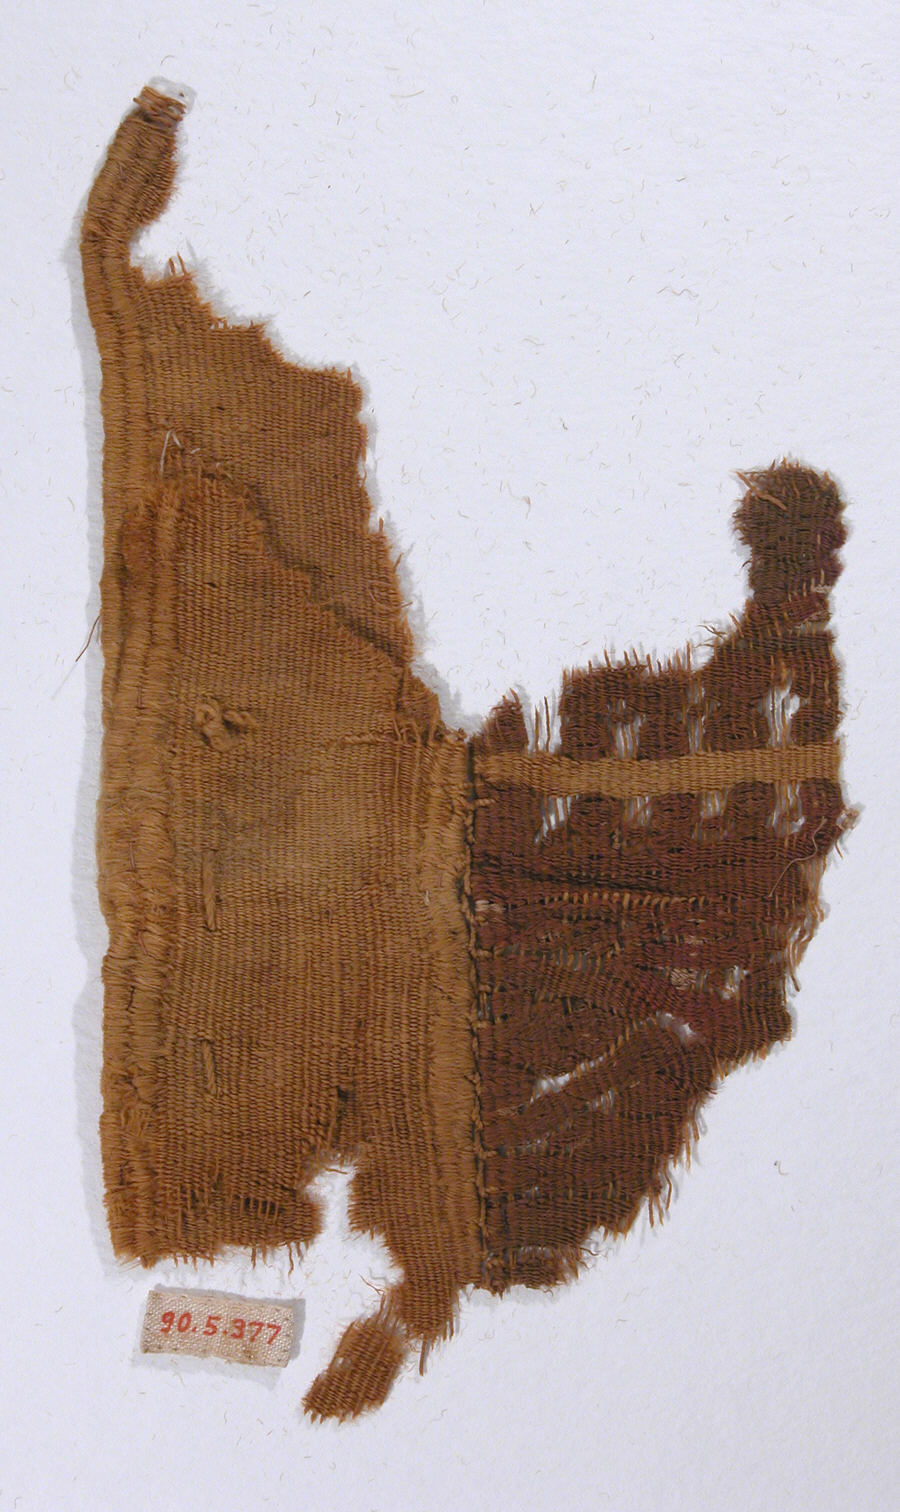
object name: textile fragment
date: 401-600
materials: linen, wool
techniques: weave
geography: egypt